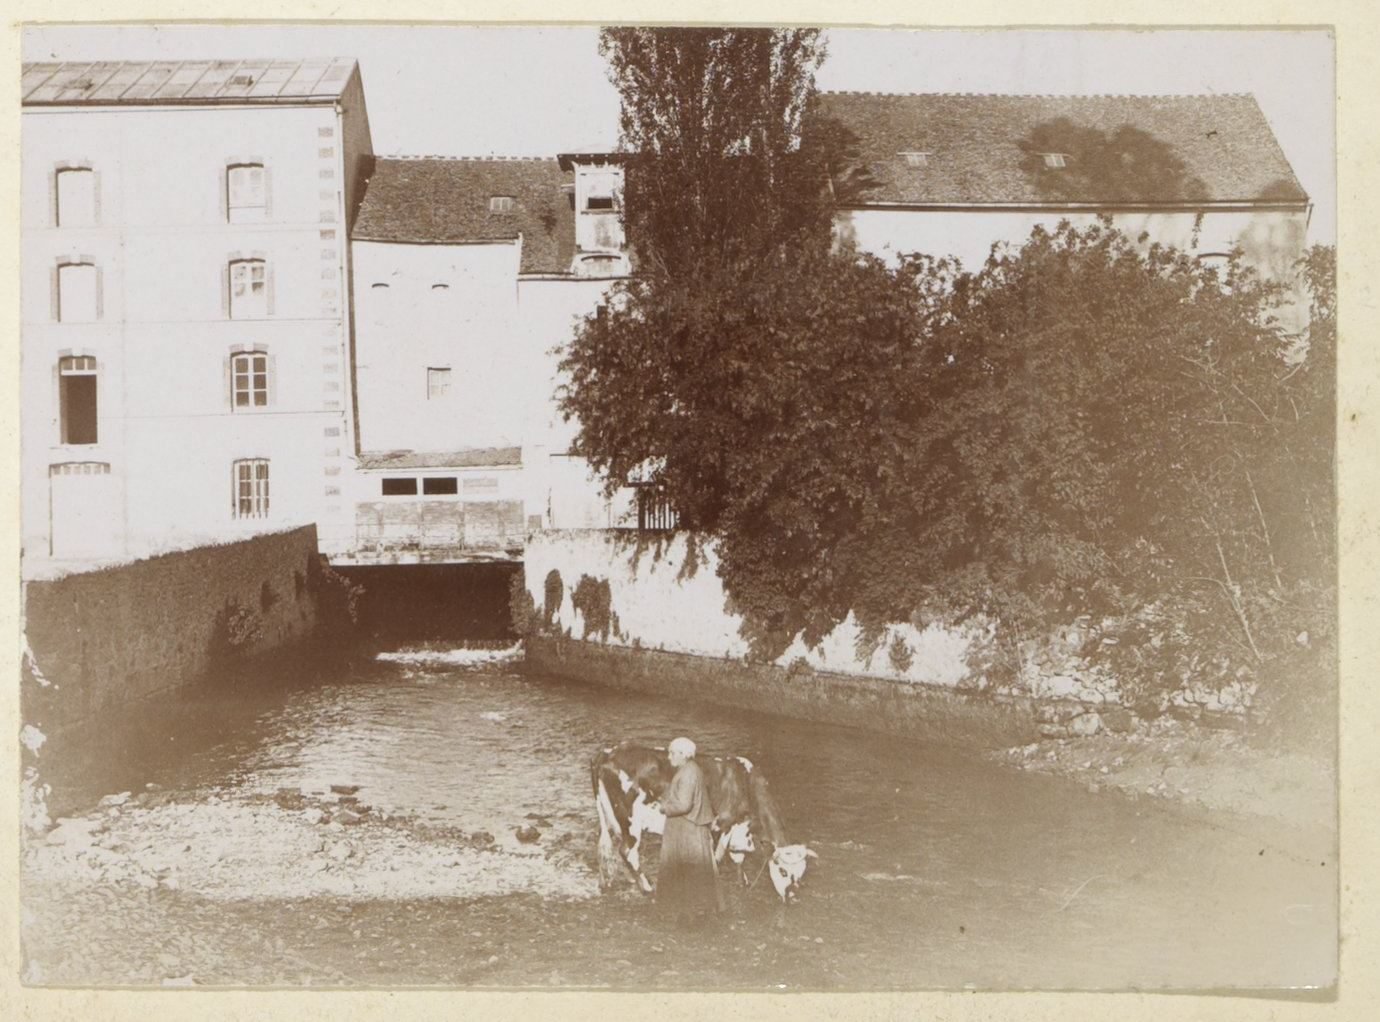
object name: photograph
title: Huis met beek eronder in Frankrijk, op de voorgrond een vrouw met een drinkend rund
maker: Anonymous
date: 1900-1910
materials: paper, photographic support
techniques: daylight paper print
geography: france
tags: brook, giving water, feeding (cattle), watermill, france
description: Onderdeel van Fotoalbum van een Franse amateurfotograaf met opnames van een familie, distilleerderij Delizy & Doistau Fils, het leger en bezienswaardigheden in Frankrijk.